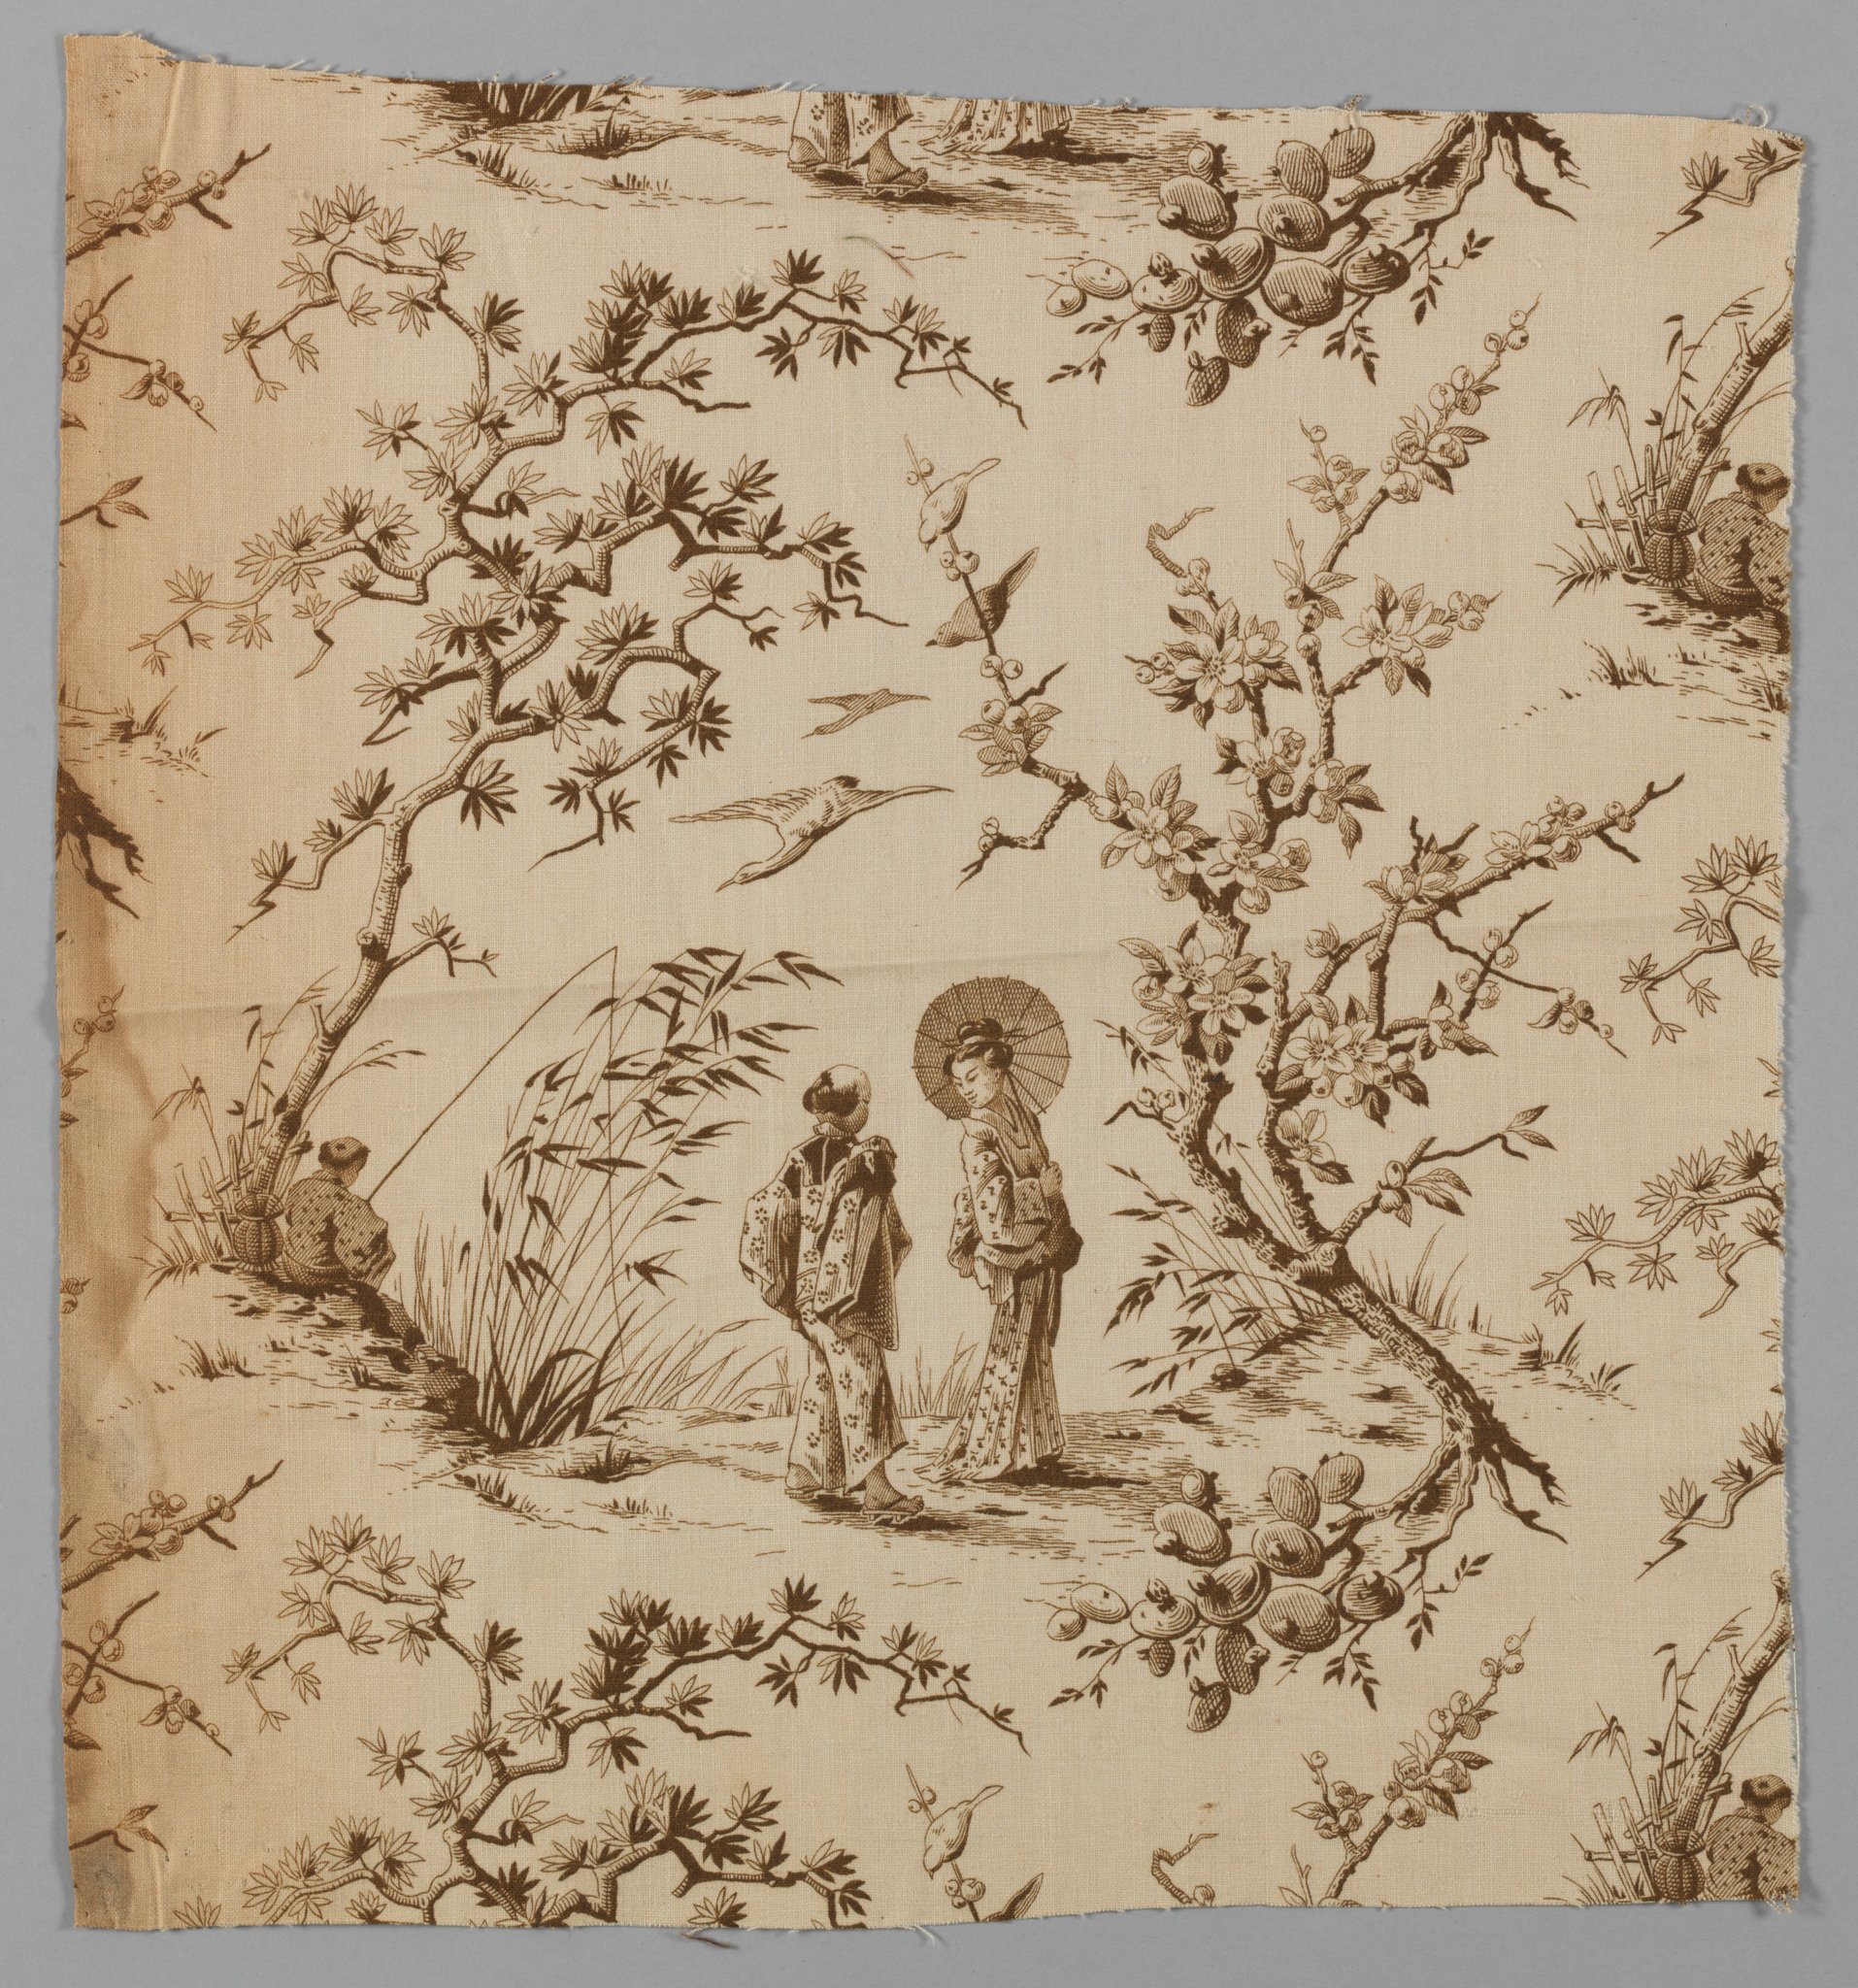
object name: piece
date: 1890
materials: cotton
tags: men,women,fishing